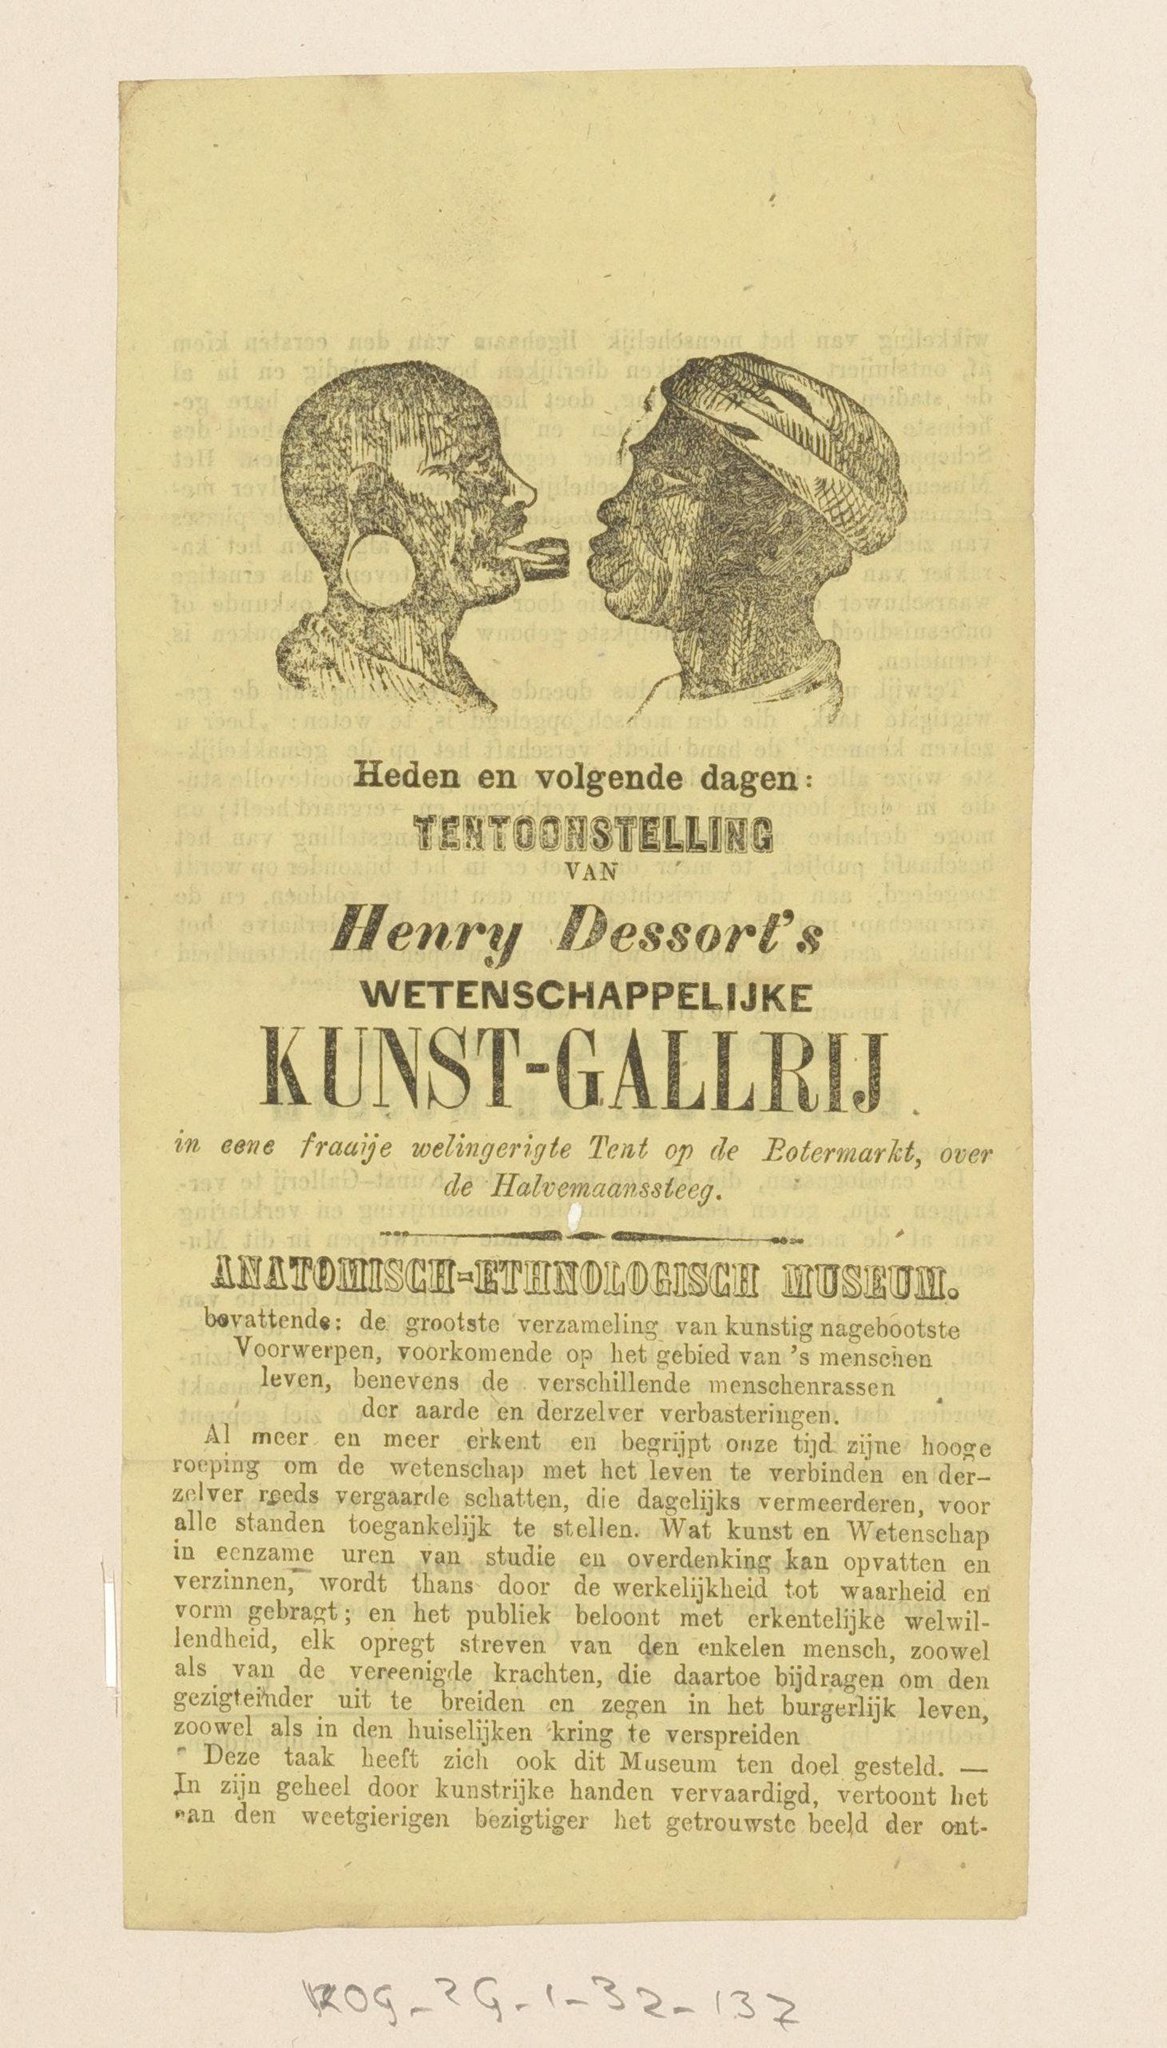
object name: programma, programmaboekje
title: Tentoonstelling van Henry Dessort's Wetenschappelijke Kunst-Gallrij (...) anatomisch-etnologisch museum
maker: adriaan hendrik van gorcum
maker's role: publisher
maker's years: 1822-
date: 1857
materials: paper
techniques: letterpress printing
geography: amsterdam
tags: wax-figure cabinet, pleasure fair and circus, human monstrosities ~ freak show, amsterdam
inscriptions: collector's mark, collector's mark: Lugt 1641